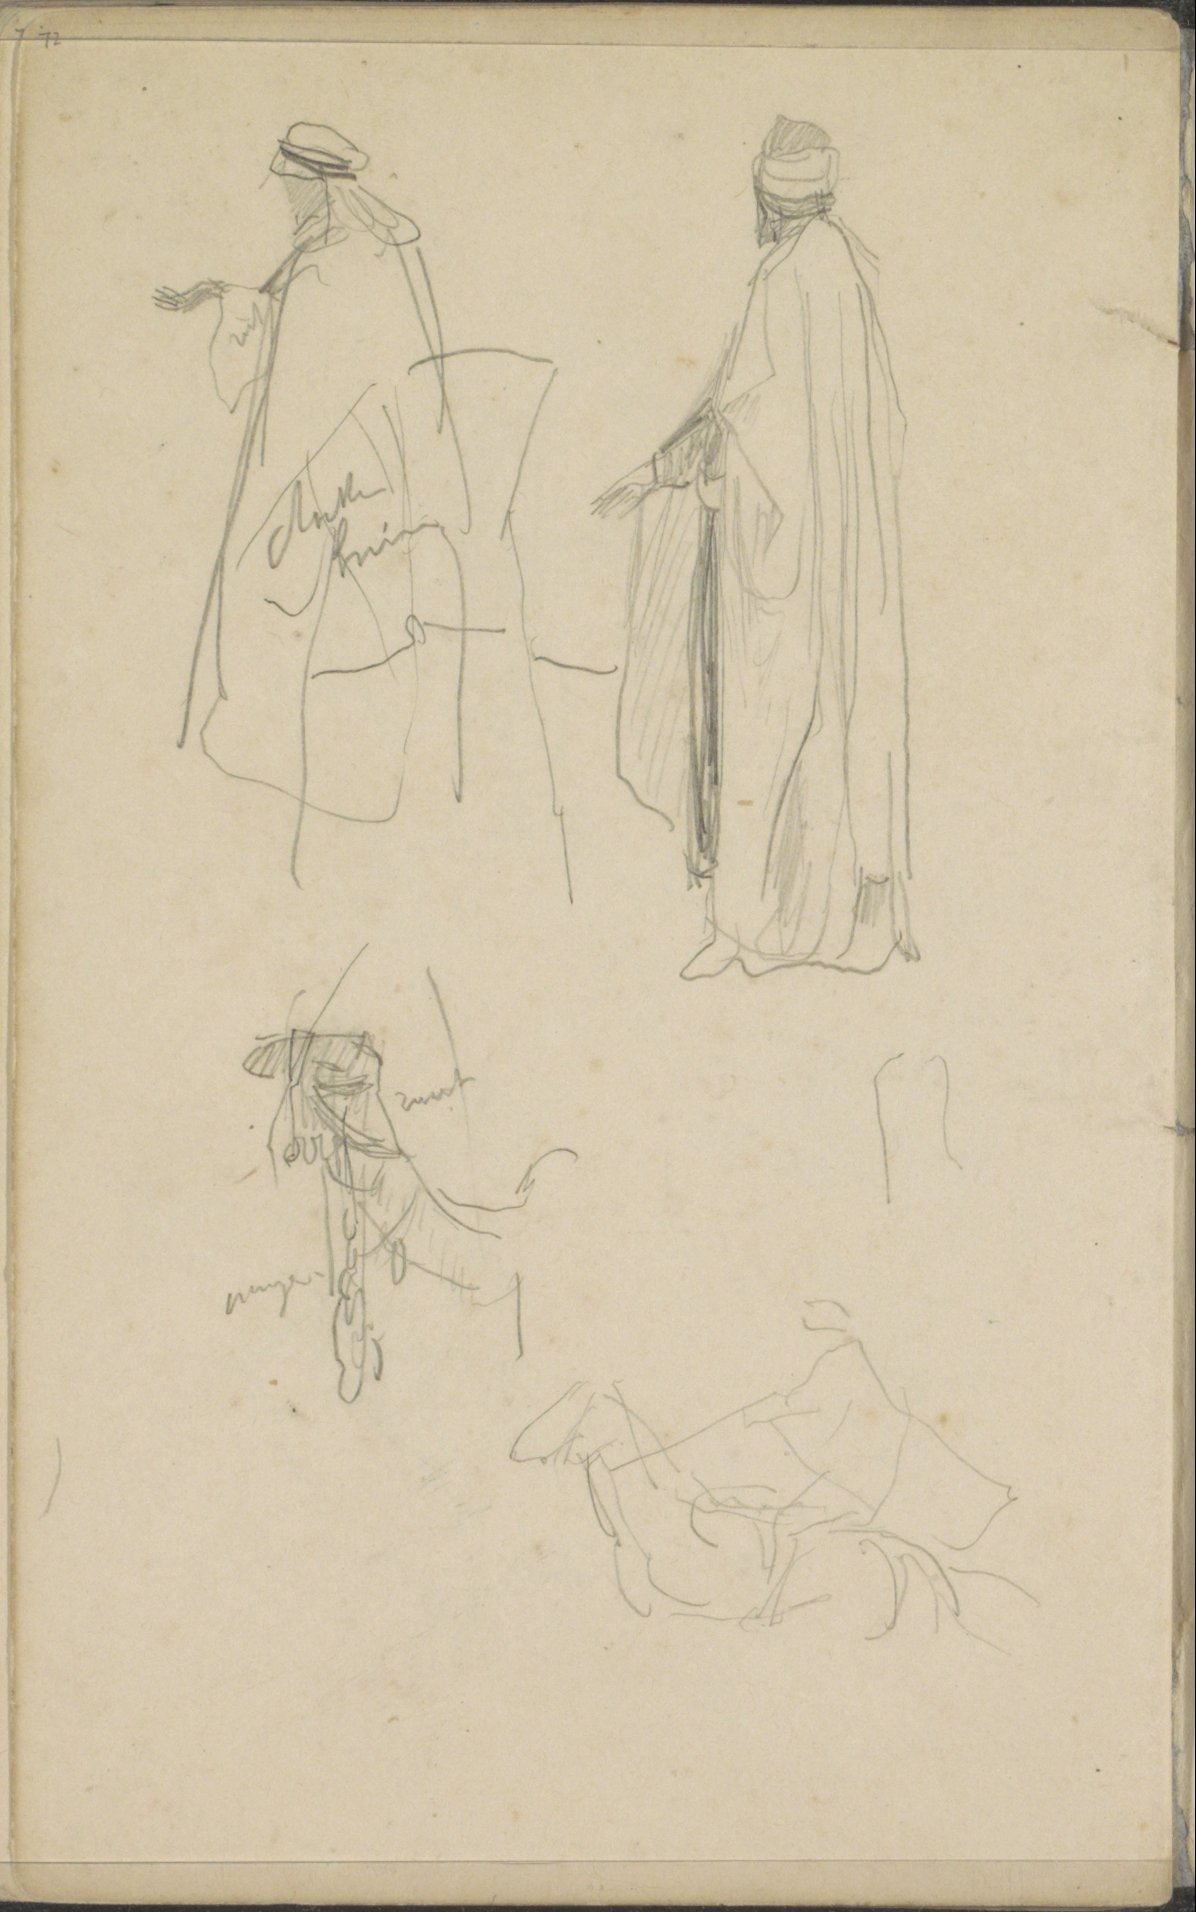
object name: sketchbook leaf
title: Arabieren, ruiter en een kop van een kameel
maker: marius bauer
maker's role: draughtsman, print maker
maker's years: 1867-1932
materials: paper, pencil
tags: riding a horse, ass, or mule; rider, horseman, hoofed animals: camel, africans, folk costume, regional costume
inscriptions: kleurnotitie, handgeschreven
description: Pagina 72 uit een schetsboek met 36 bladen.